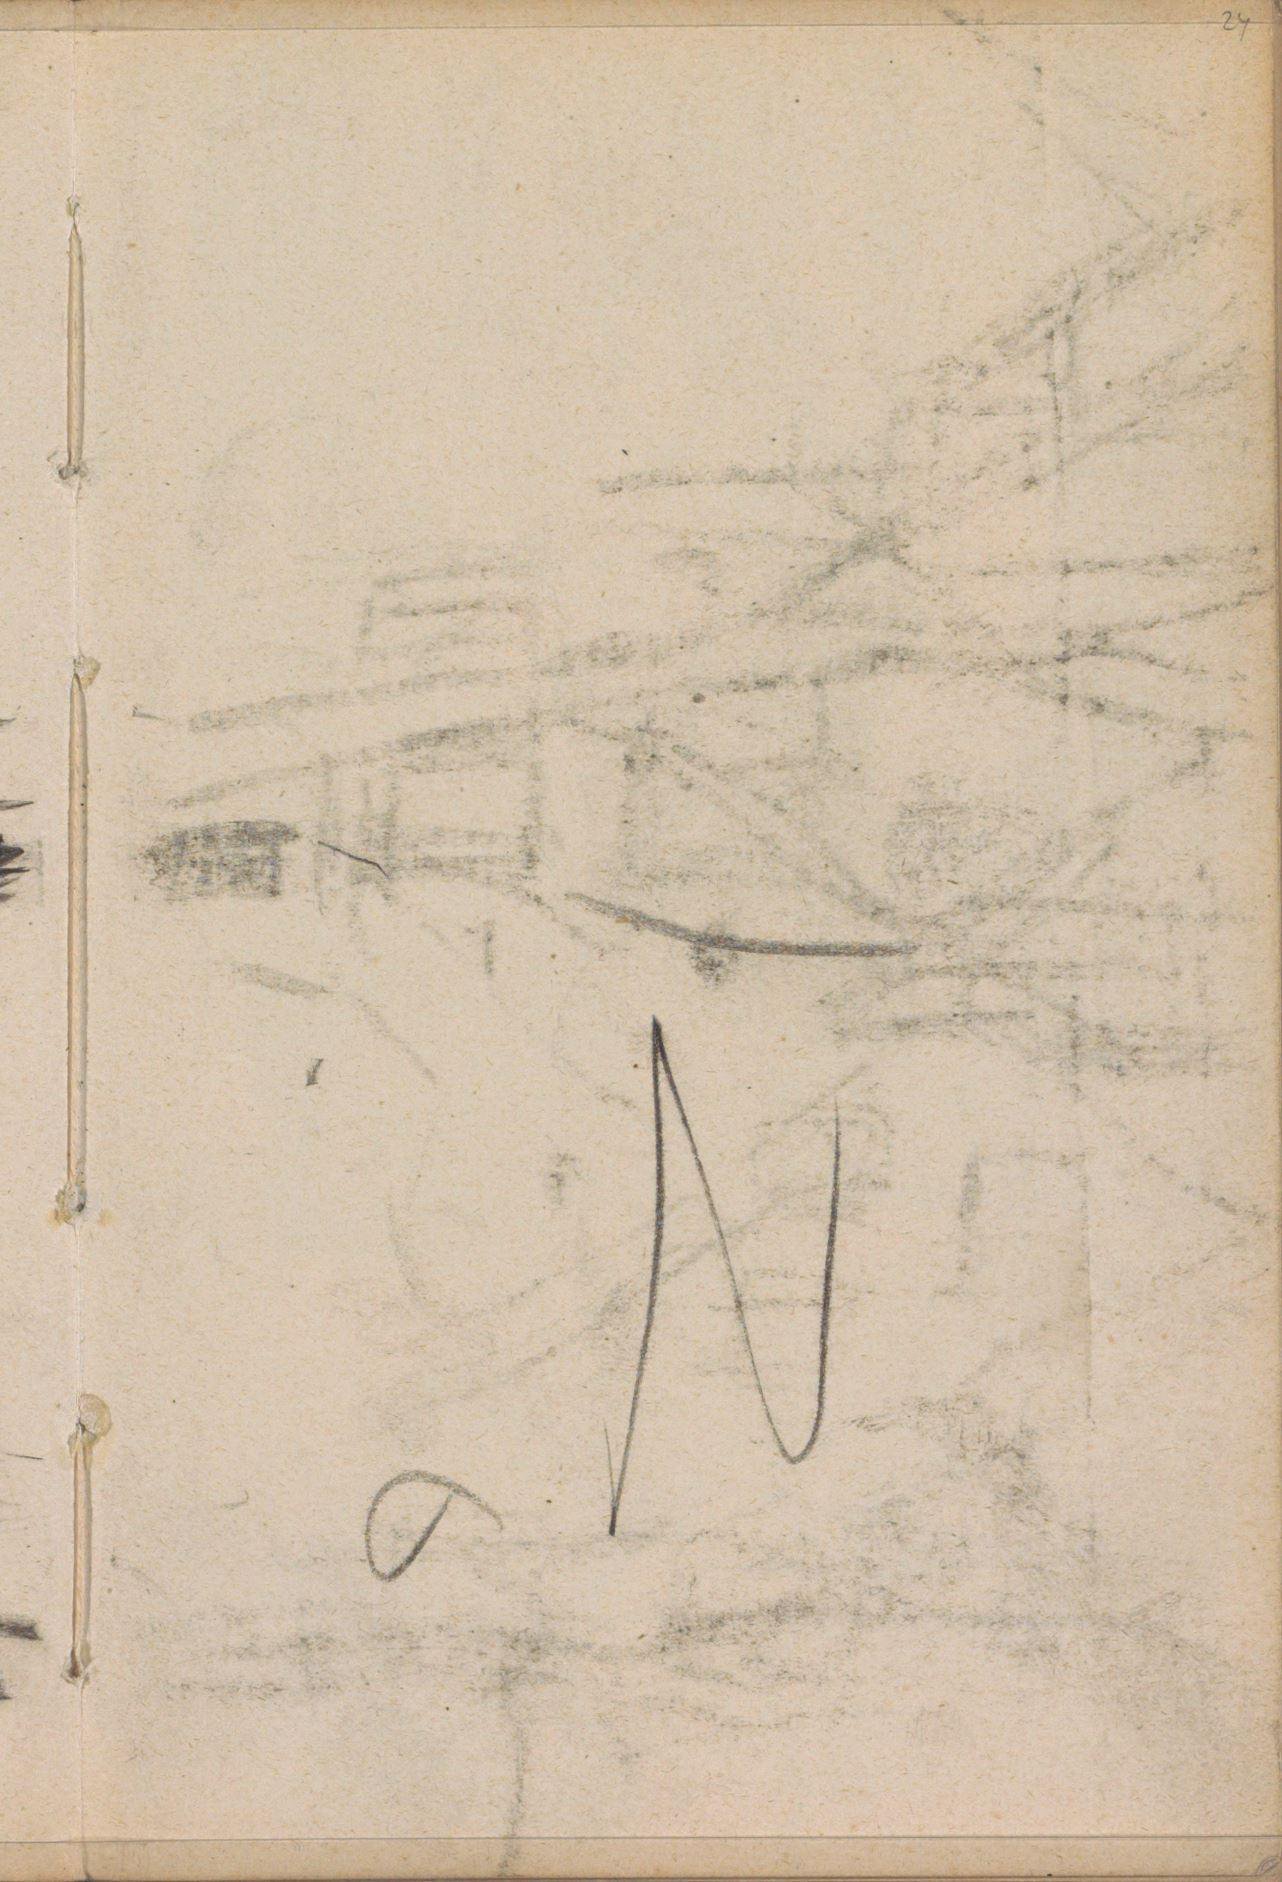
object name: sketchbook leaf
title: Studie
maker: george hendrik breitner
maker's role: draughtsman, painter, print maker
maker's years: 1857-1923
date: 1900-1923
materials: chalk, paper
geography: amsterdam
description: Pagina 24 uit een schetsboek met 39 bladen.